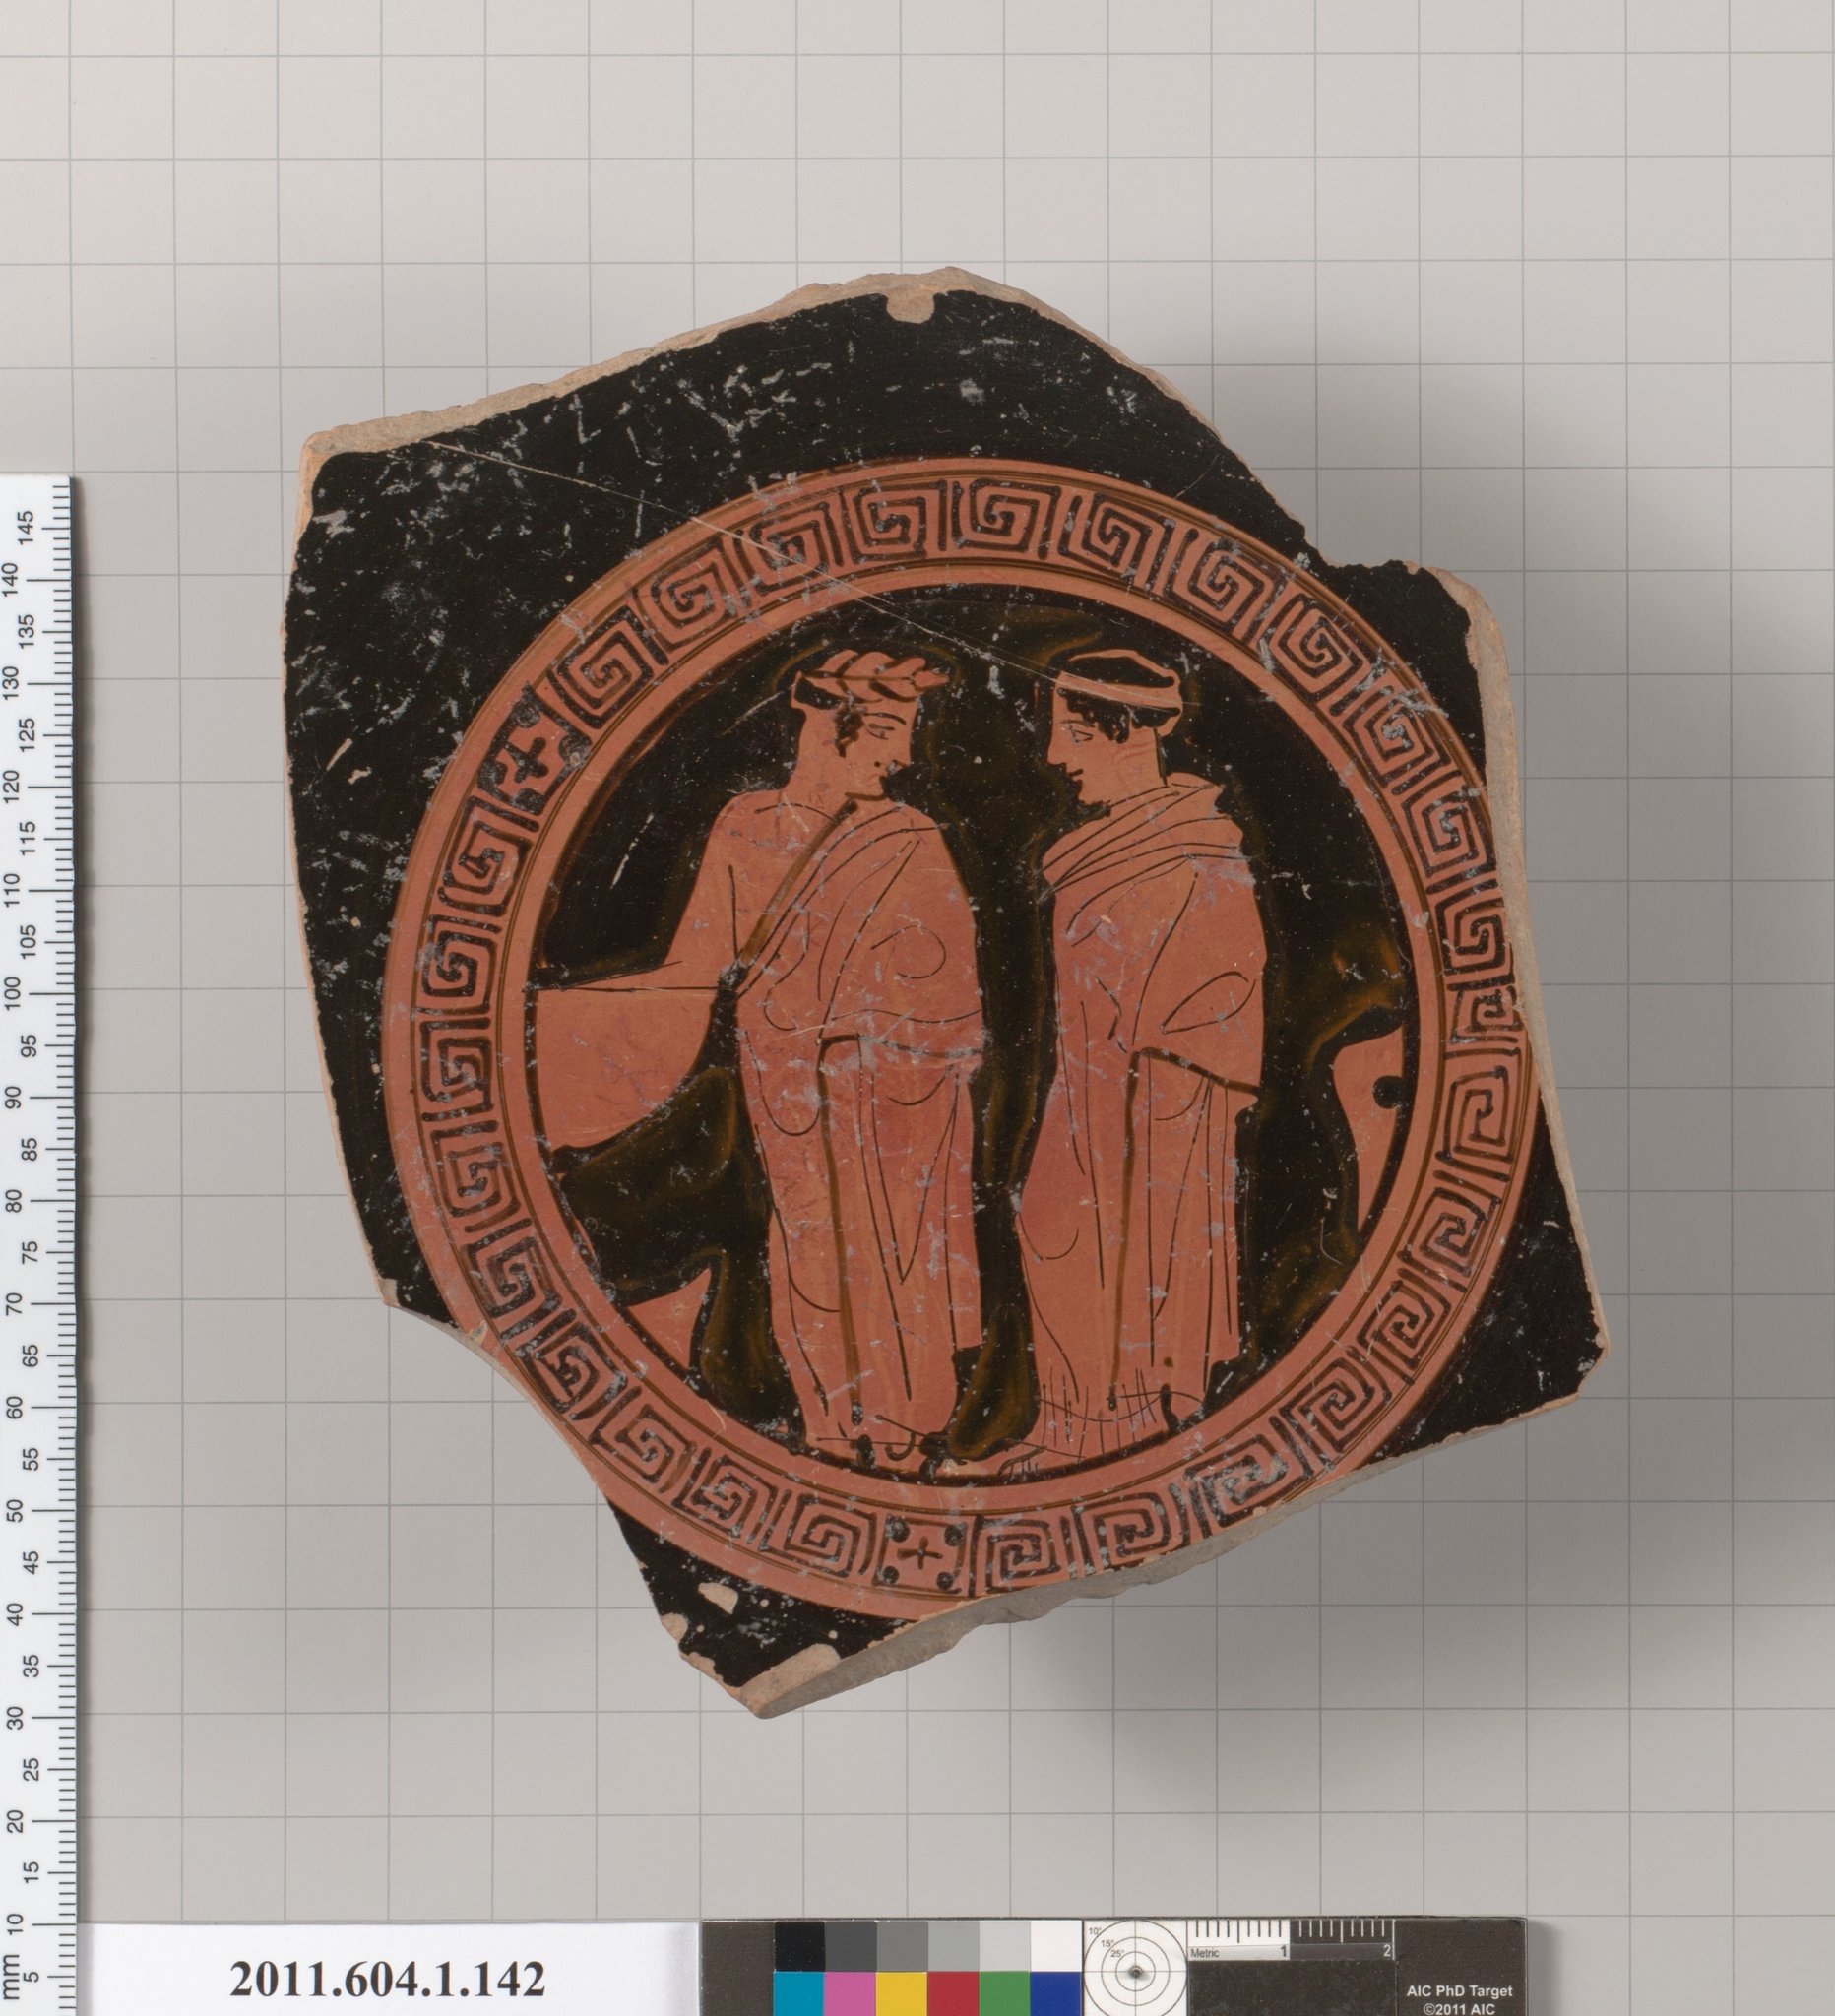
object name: kylix fragment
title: Terracotta fragment of a kylix (drinking cup)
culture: greek, attic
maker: veii painter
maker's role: artist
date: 475-451 BCE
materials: terracotta